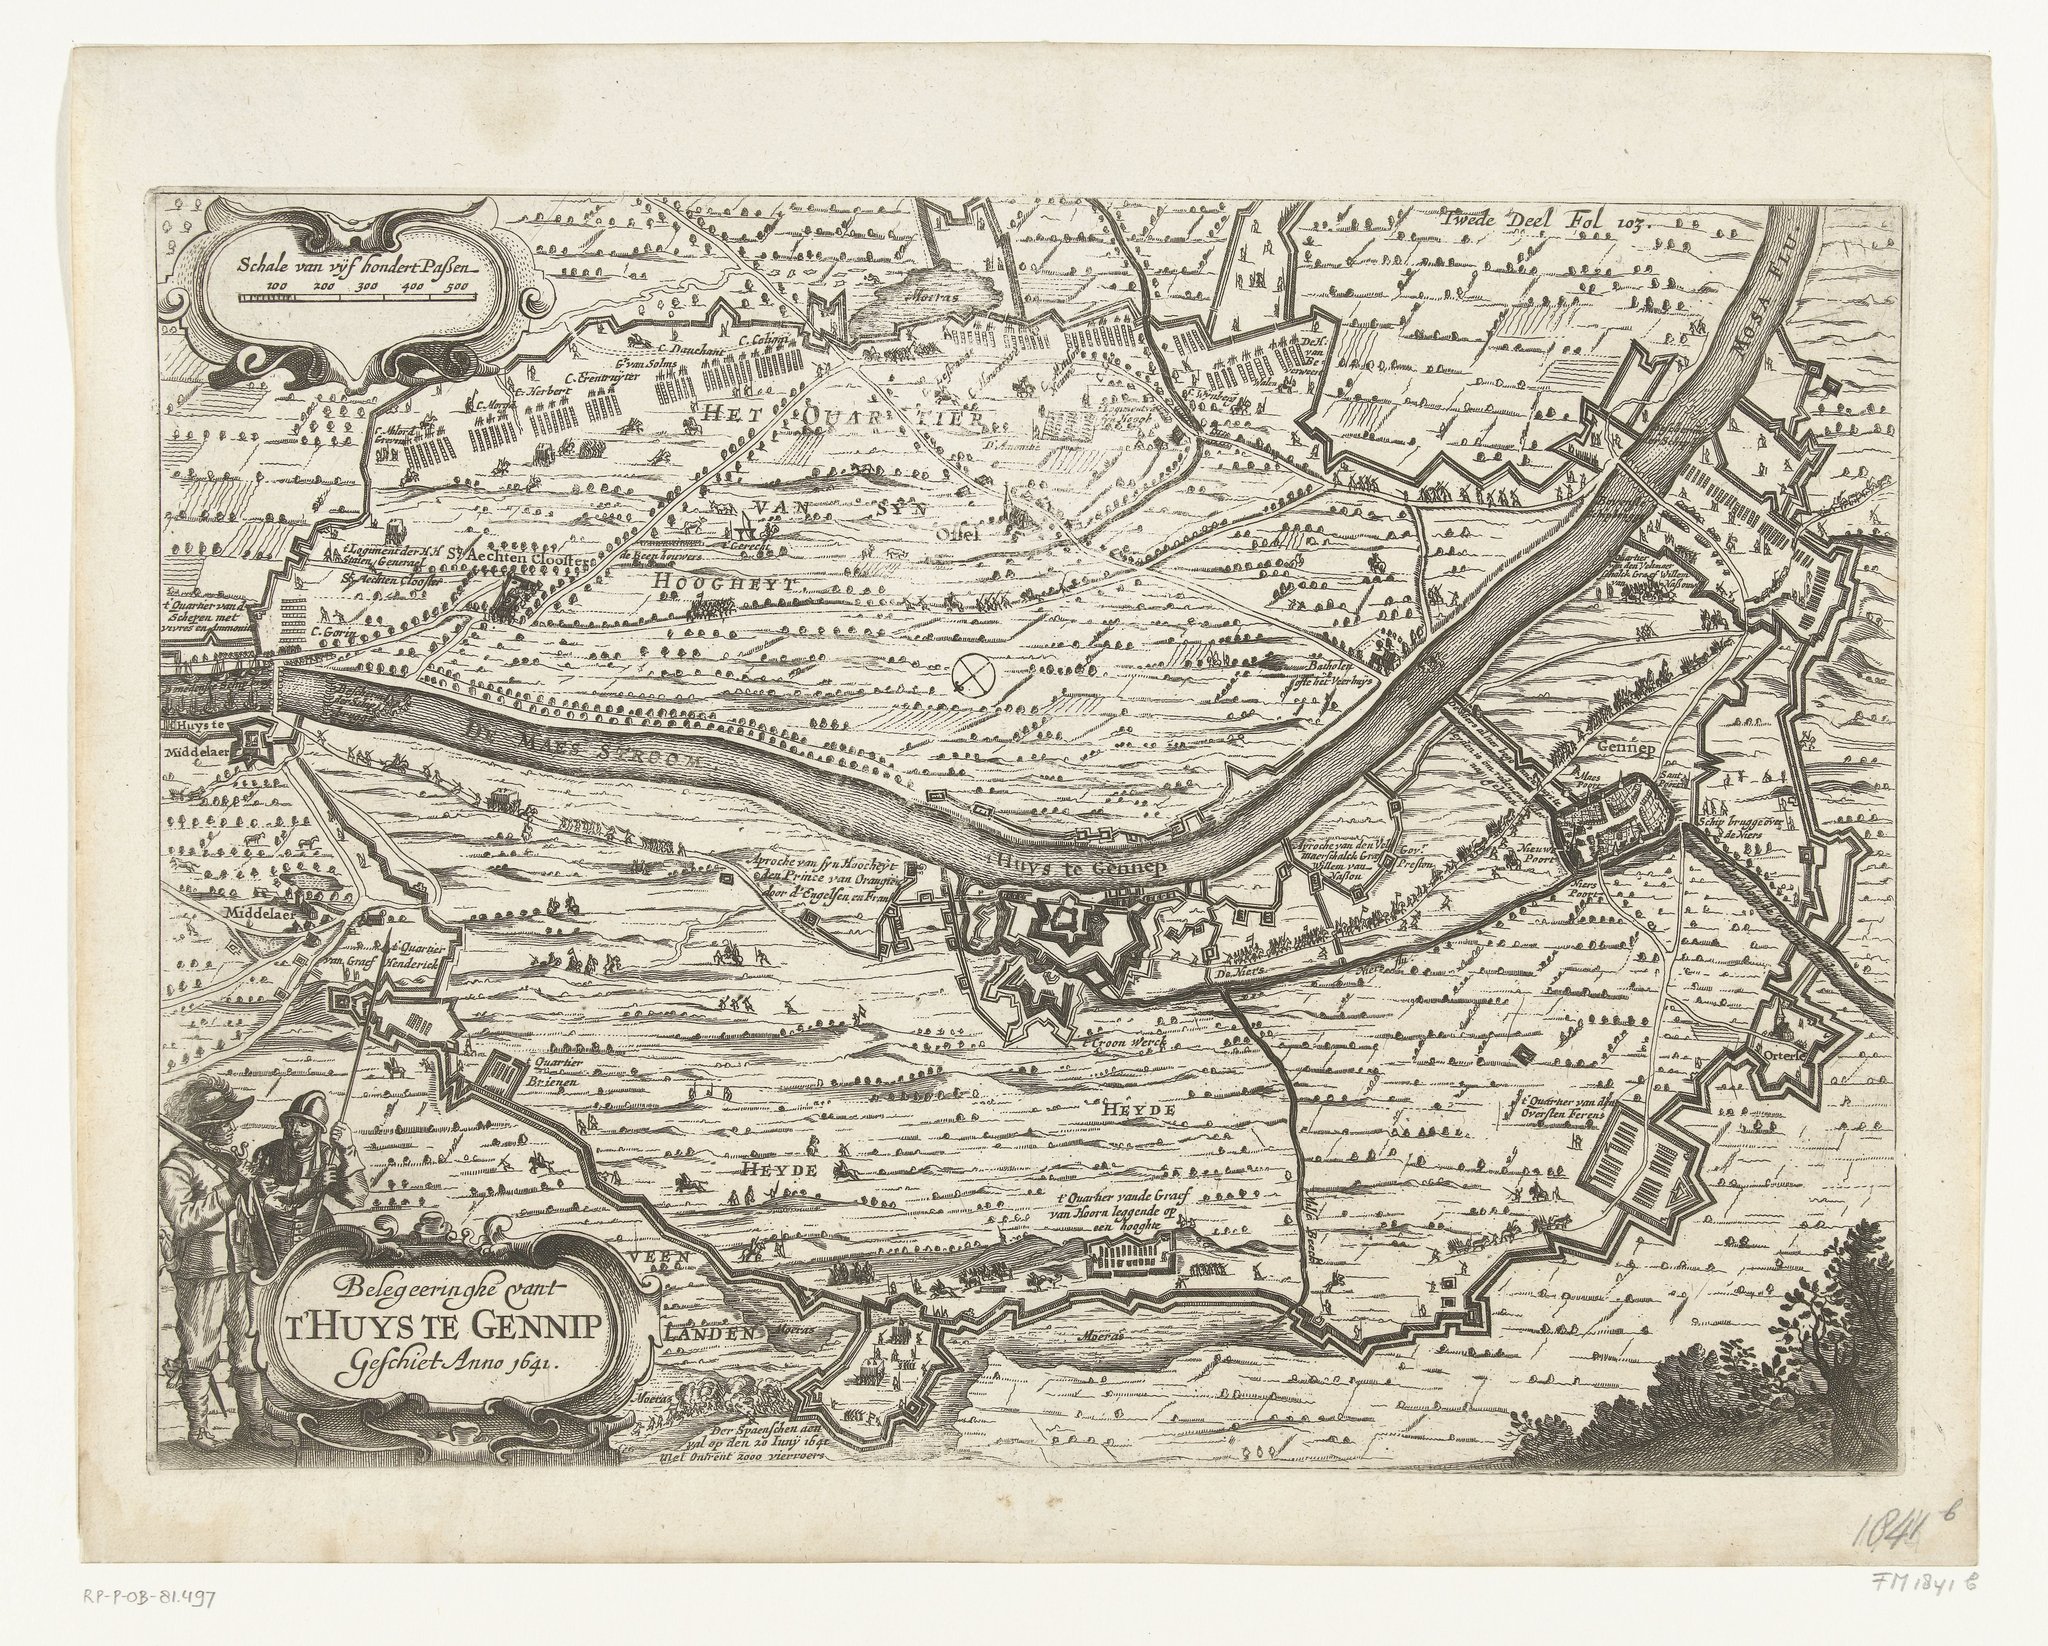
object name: history print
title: Kaart van het beleg van Gennep, 1641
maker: Anonymous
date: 1651-1652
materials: paper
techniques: etching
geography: northern netherlands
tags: delft, frederick henry (prince of orange), maps of separate countries or regions, siege, position war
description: Kaart van Gennep met het Huis te Gennep en omgeving, belegerd en veroverd door het Staatse leger onder Frederik Hendrik, 6 juni - 27 juli 1641. Met de circumvallatielinie van de belegeraars en de hun legerkampen. Linksonderaan twee soldaten bij de cartouche met de titel. Rechtsboven gemerkt: Twede Deel Fol 103.